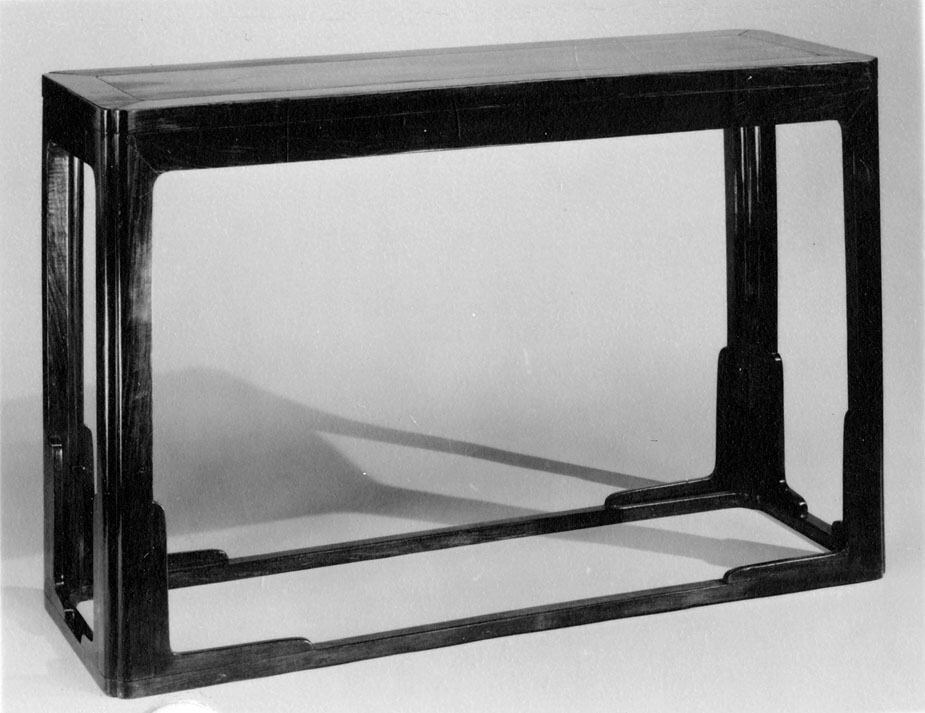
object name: side table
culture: chinese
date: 1501-1600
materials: wood